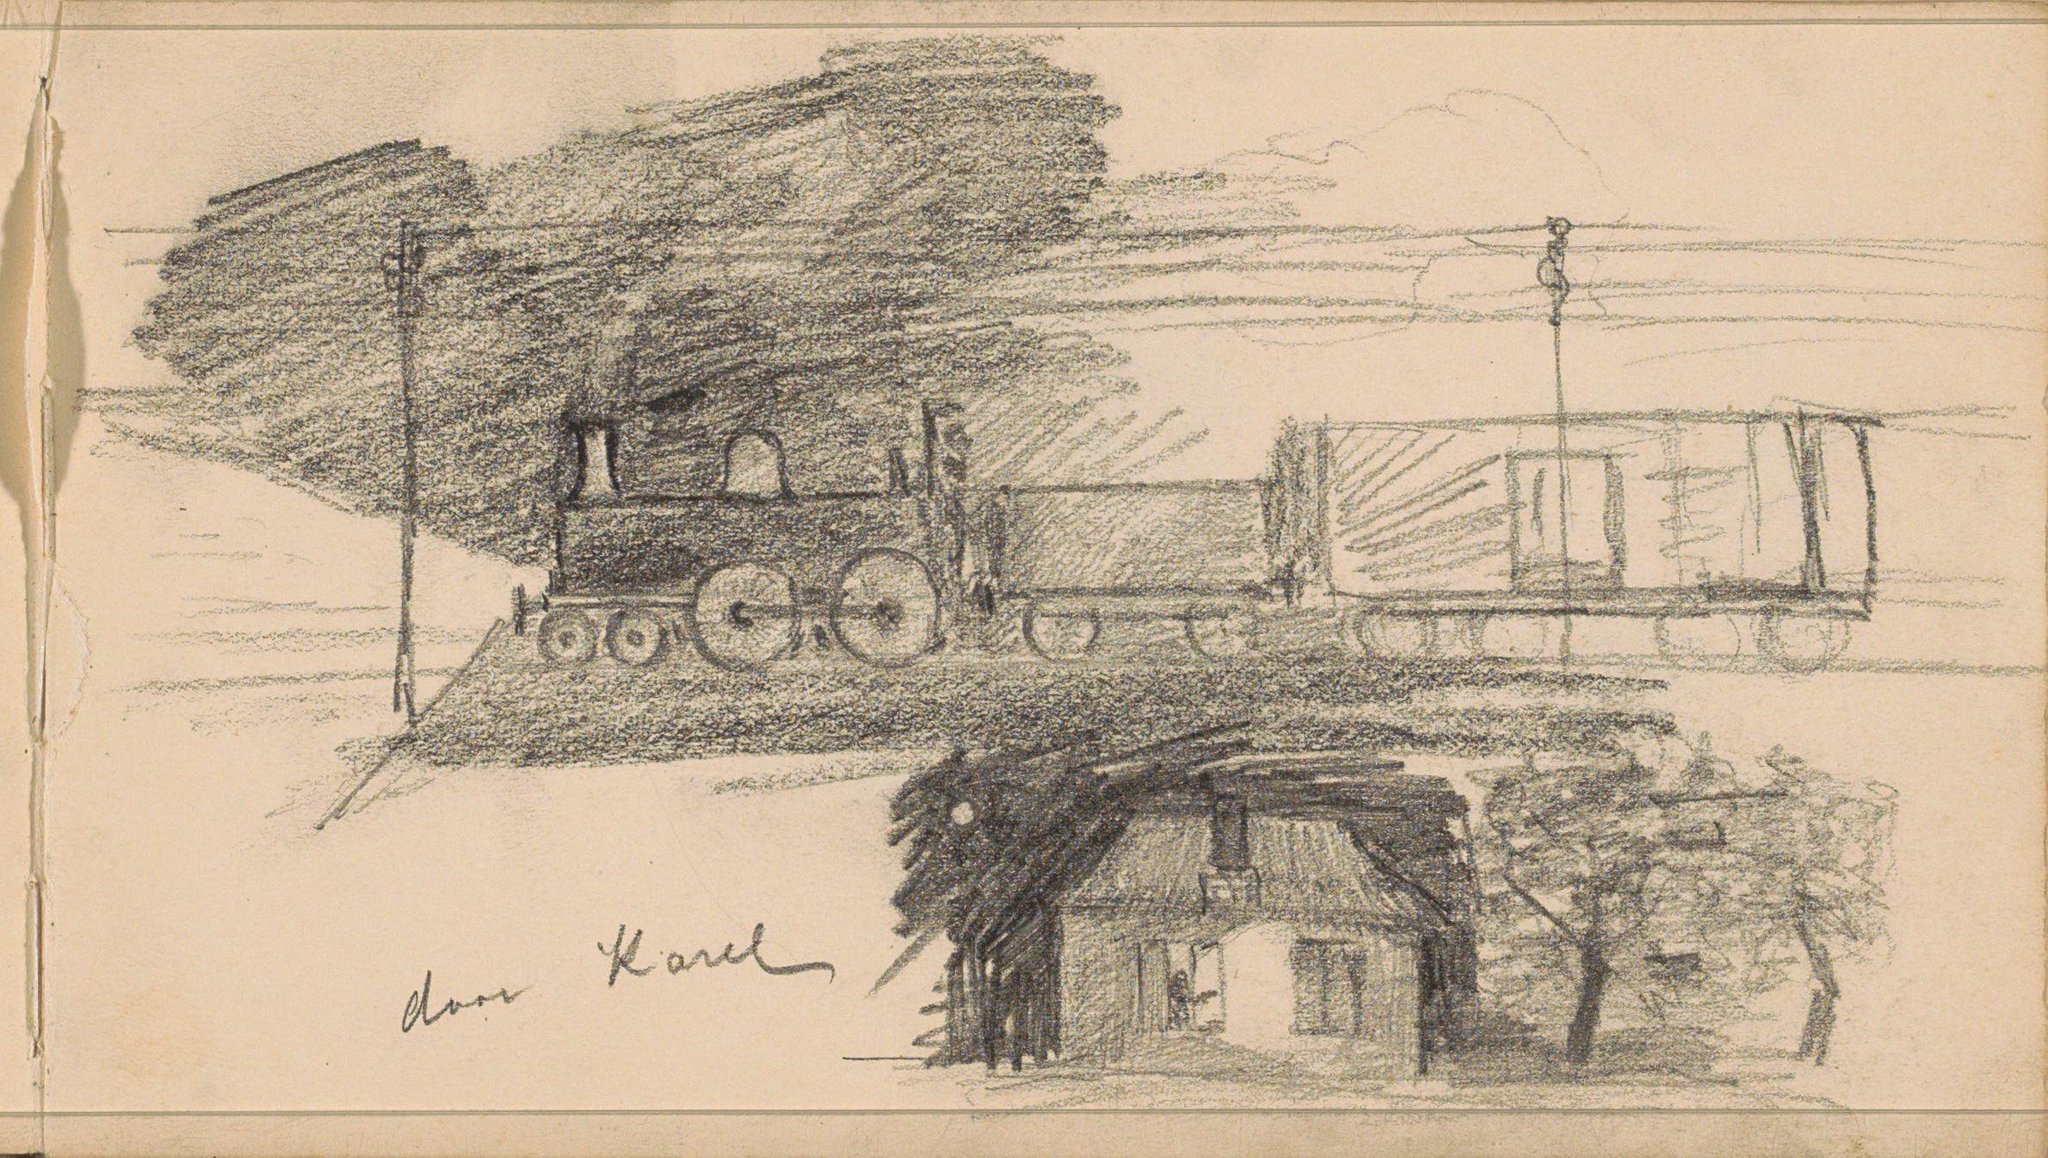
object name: sketchbook leaf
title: Stoomlocomotief en een huis met een schoorsteen naast twee bomen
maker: julie de graag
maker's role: draughtsman, print maker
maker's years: 1877-1924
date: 1892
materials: paper, pencil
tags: trees, housing, steam locomotive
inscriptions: annotation: ‘door Karel’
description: Blad 16 recto uit een schetsboek met 22 bladen.